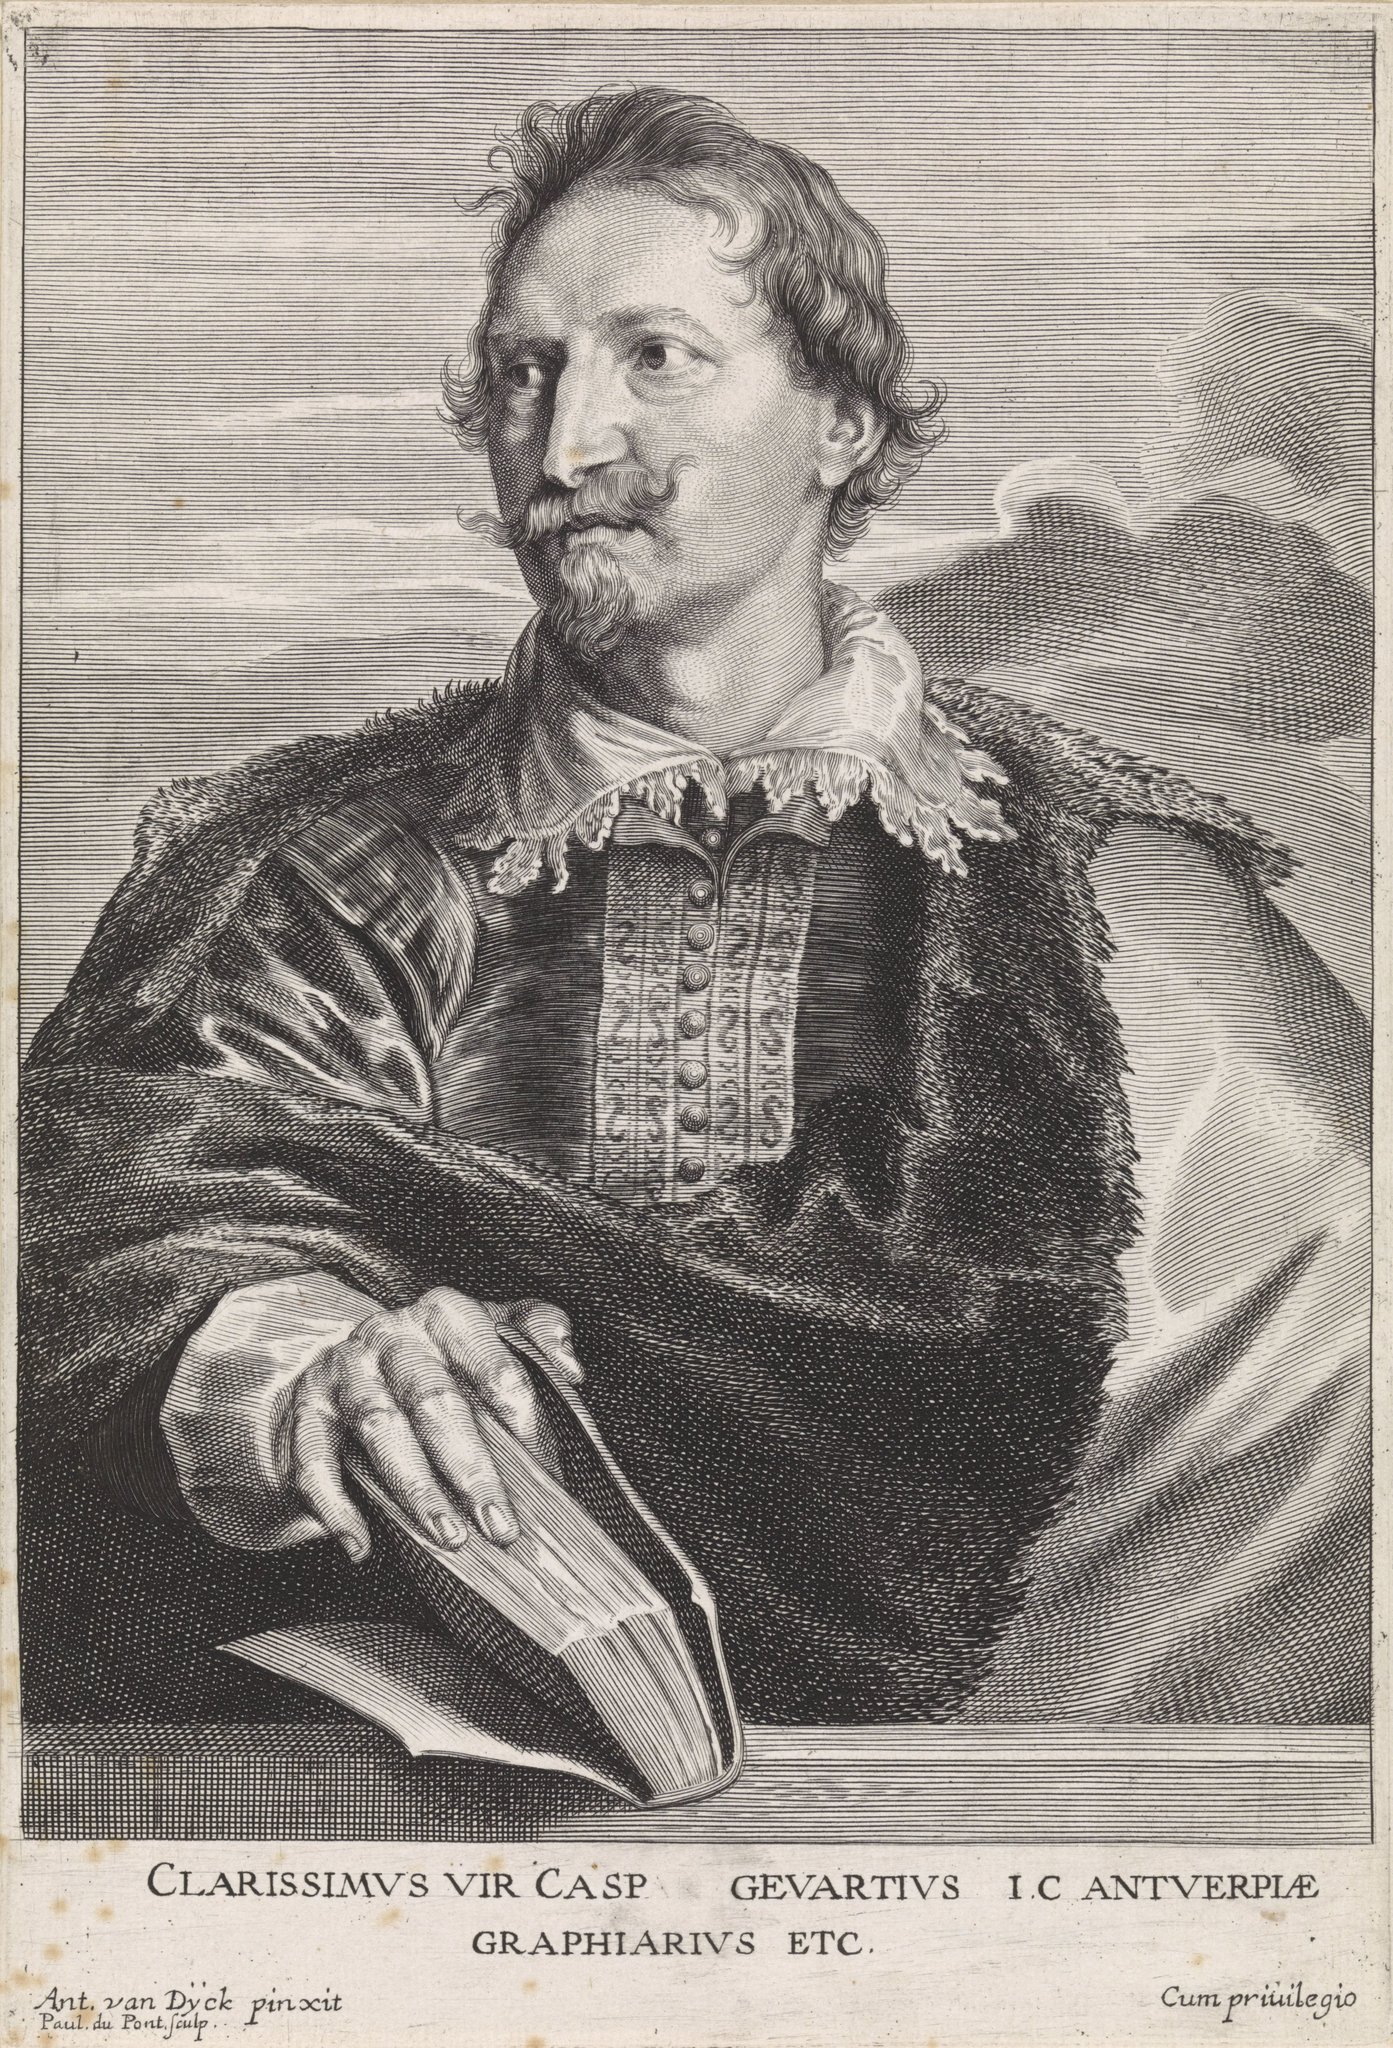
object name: print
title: Portret van de jurist Jan-Gaspar Gevartius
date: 1616-1657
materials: paper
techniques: engraving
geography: antwerp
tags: antwerp, politician, jean gaspard gevartius, book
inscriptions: collector's mark: Lugt 240